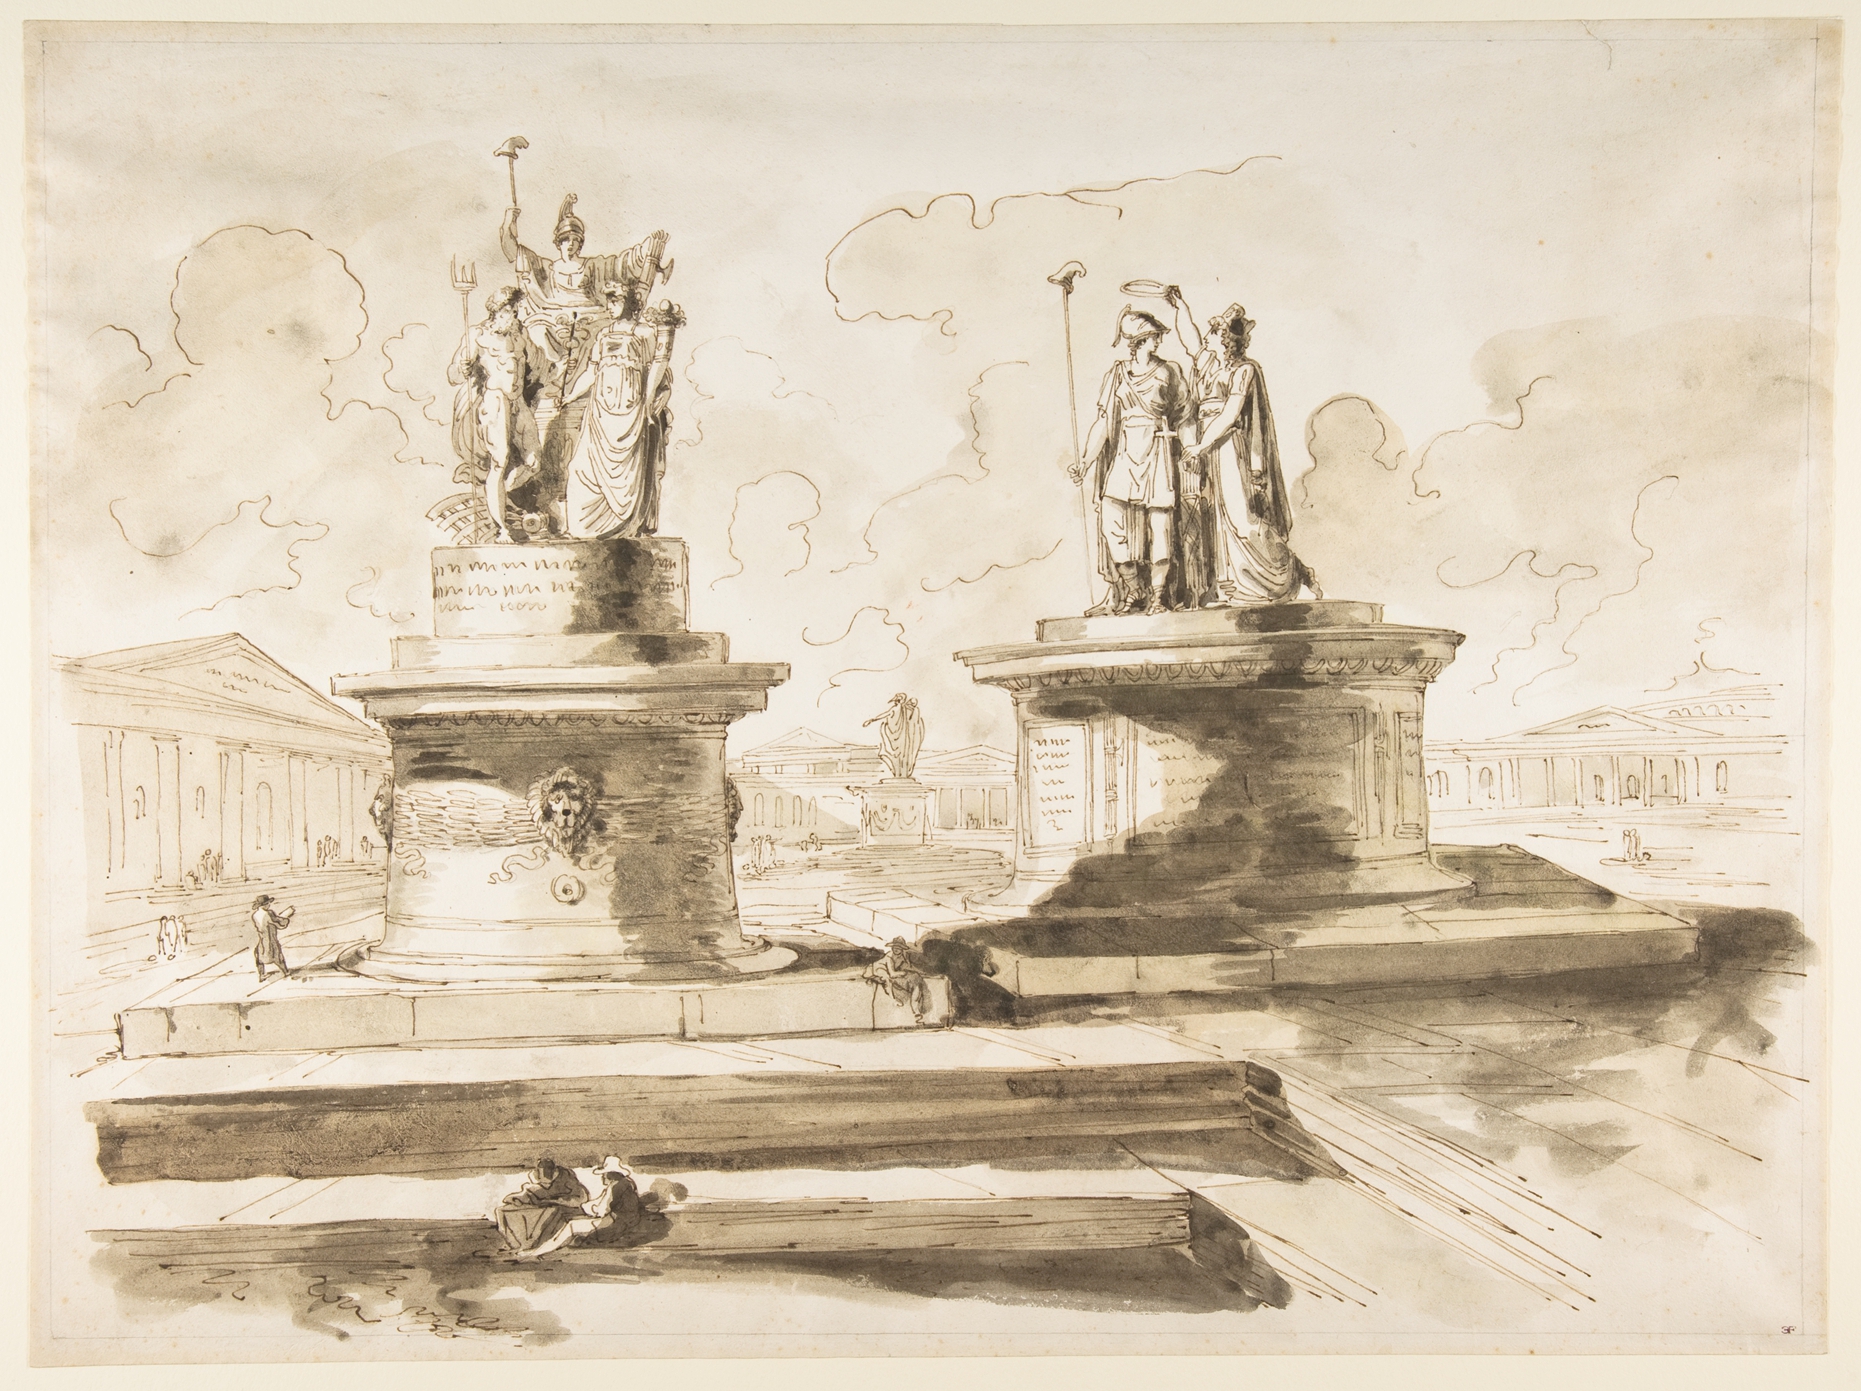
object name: drawing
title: Two sculptures on pedestals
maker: felice giani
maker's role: artist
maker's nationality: italian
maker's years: 1758-1823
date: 1701-1900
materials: ink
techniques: pen, wash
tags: sculpture